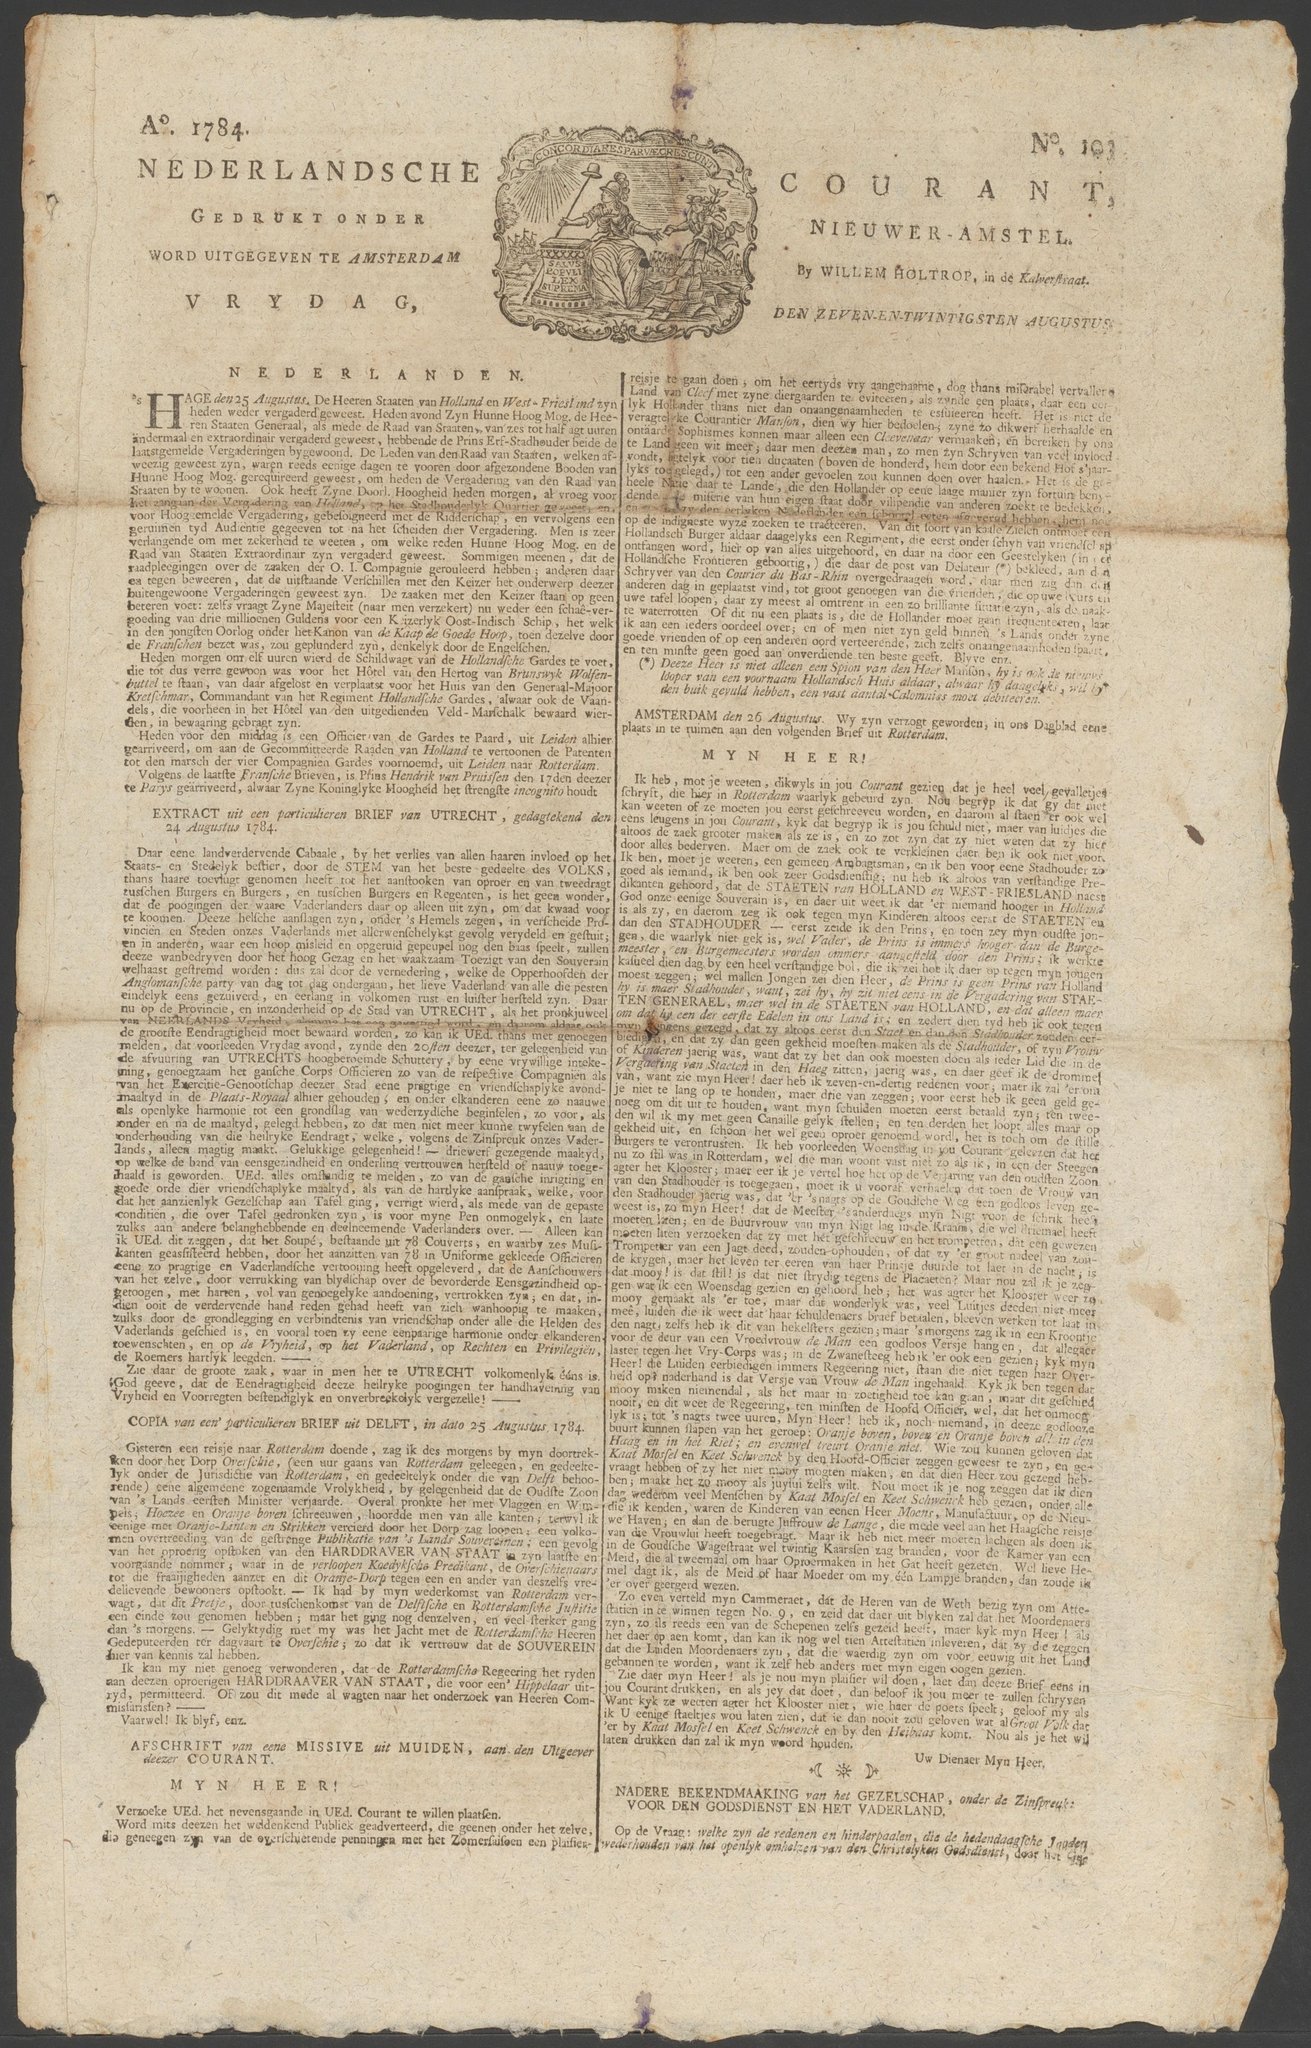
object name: newspaper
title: Nederlandsche Courant, 27 augustus 1784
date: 1784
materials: paper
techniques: letterpress printing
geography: nieuwer-amstel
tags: newspaper, news-sheet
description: Exemplaar van de krant 'Nederlandsche Courant' van 27 augustus 1784. Enkelbladig, beide zijden bedrukt. Bovenaan een vignet met de Vrijheid en Mercurius. Onderwerpsrubrieken binnen de Atlas Zeden en Gewoonten: Regeering, Officieele Nieuwsbladen.